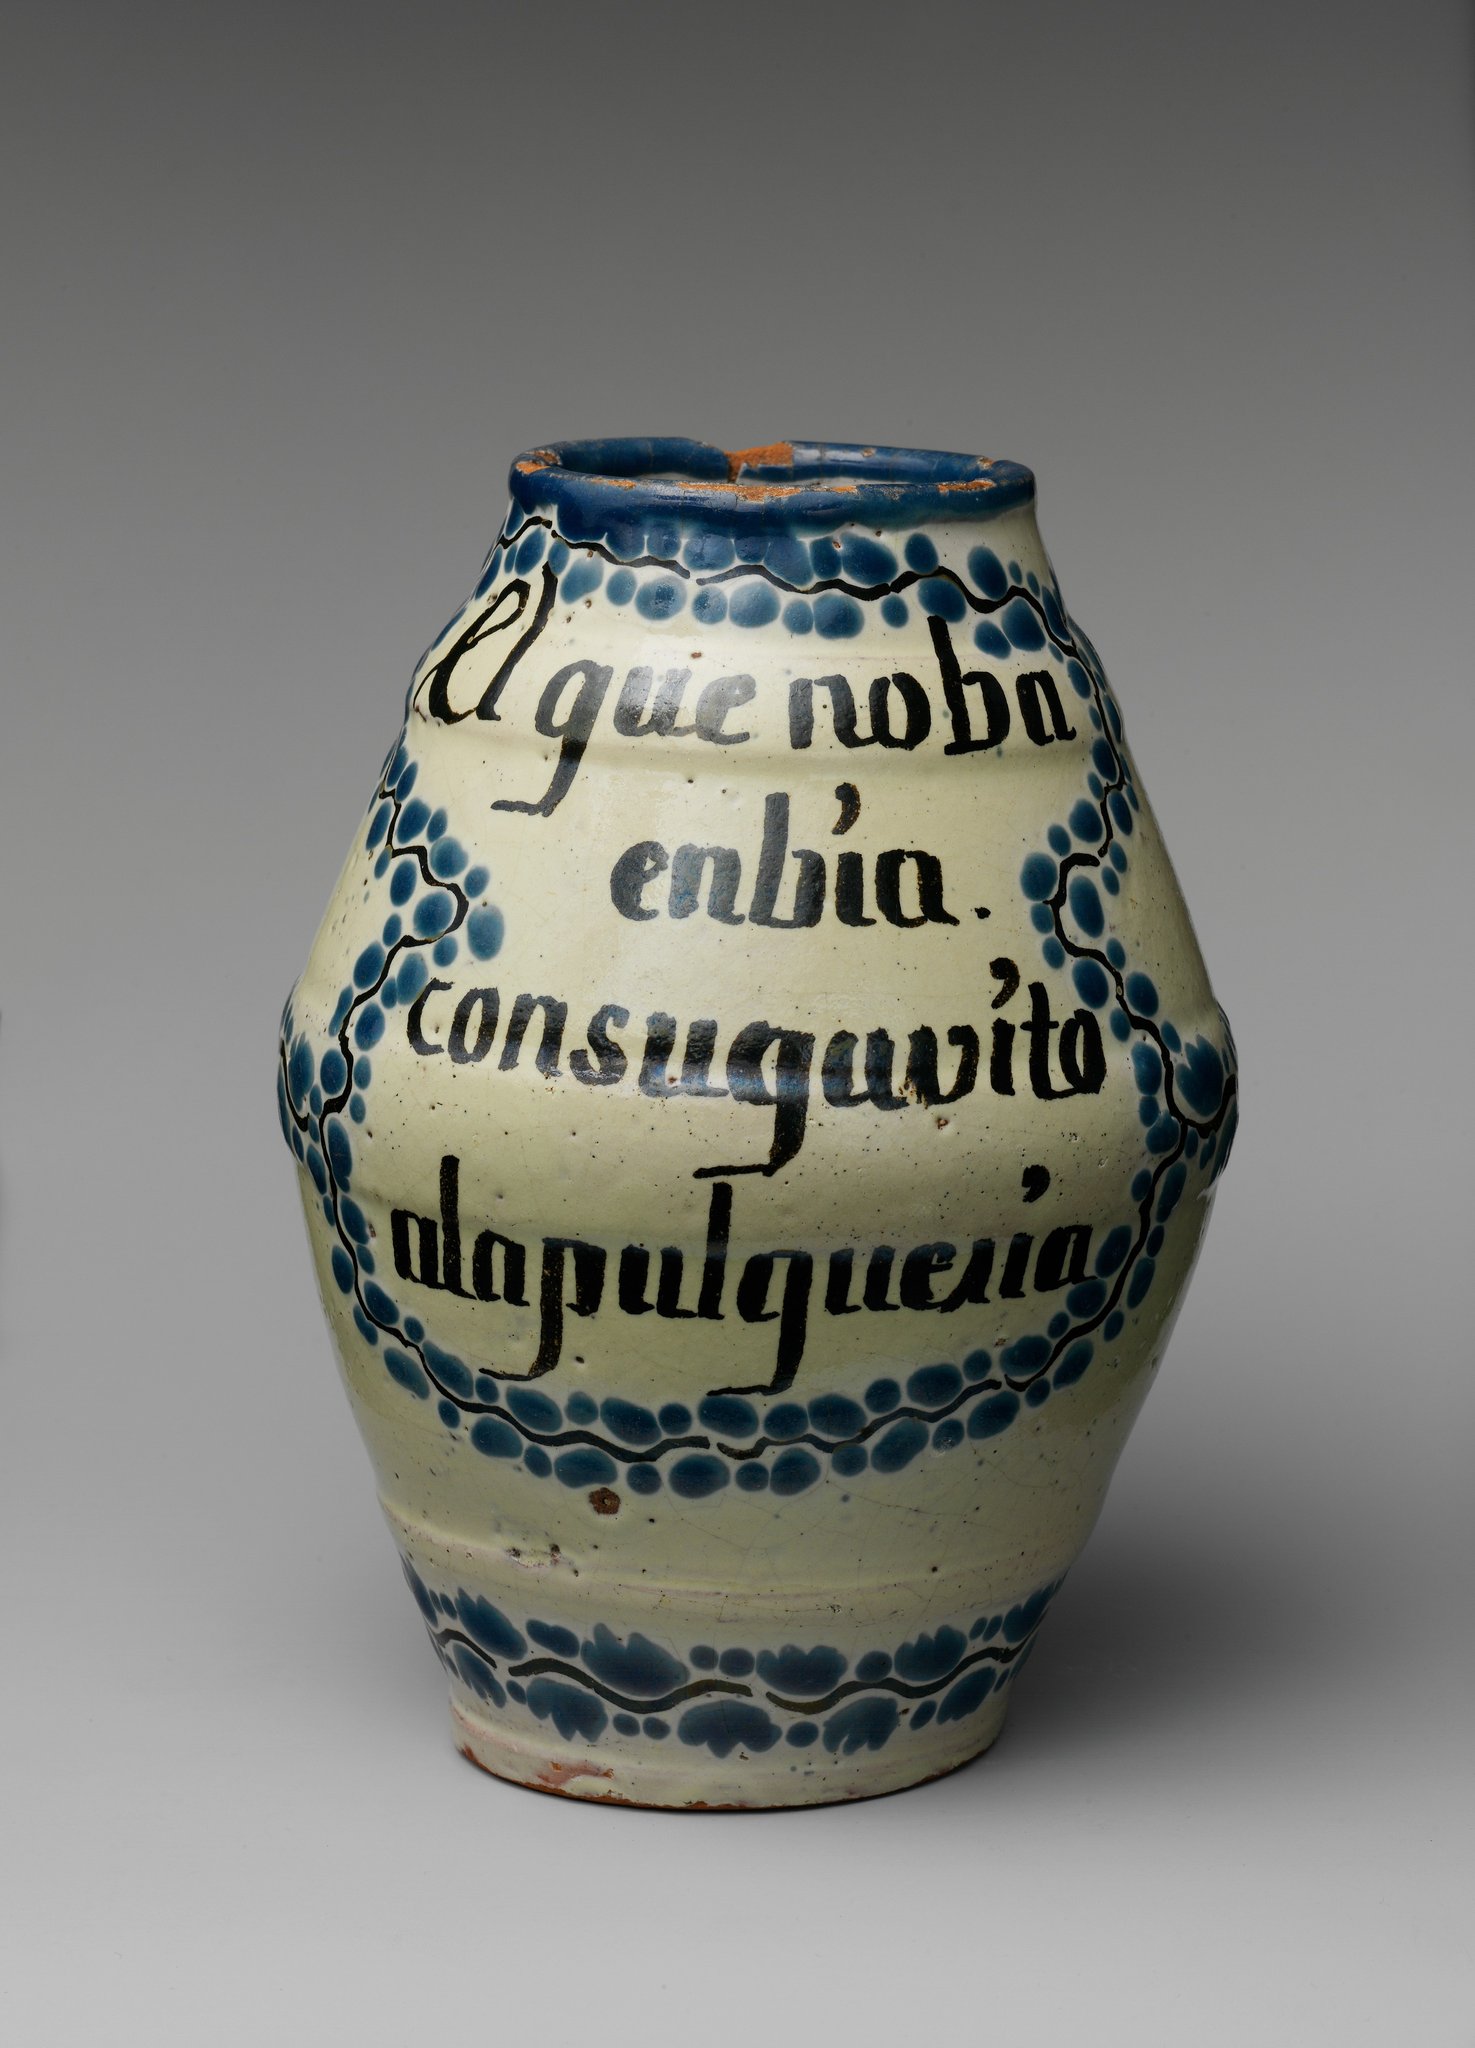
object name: jug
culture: mexican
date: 1800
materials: earthenware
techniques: glazing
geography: mexico